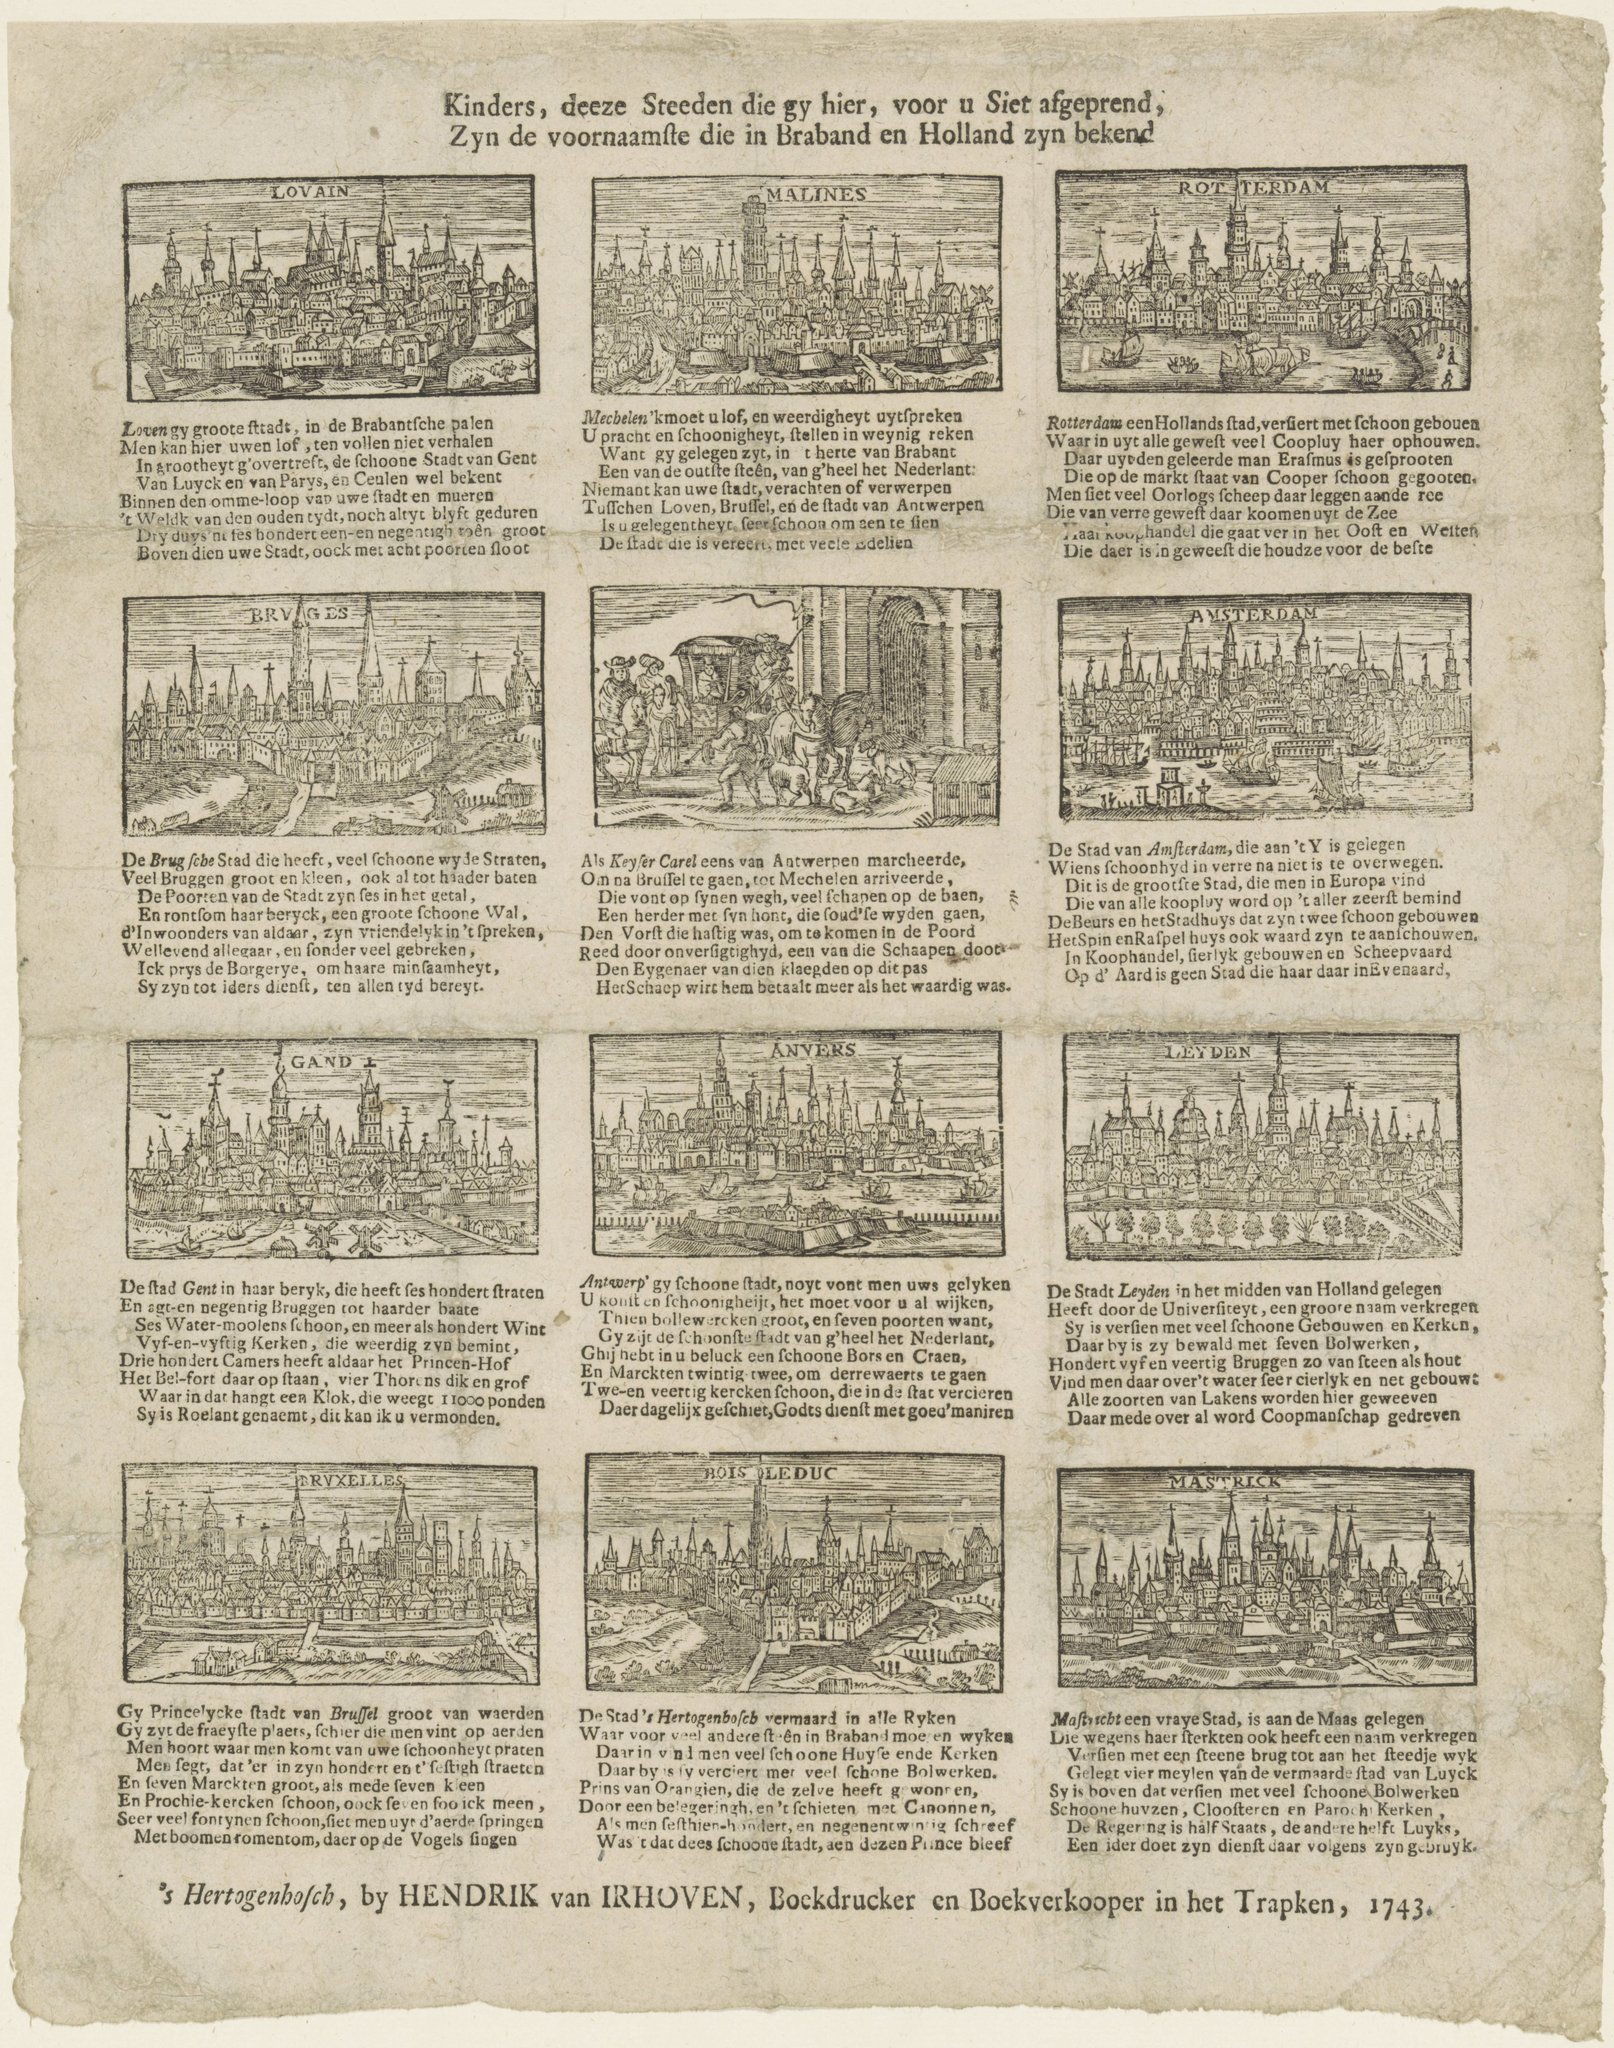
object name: popular print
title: Kinders, deeze steeden die gy hier, voor u siet afgeprend, / Zyn de voornaamste die in Braband en Holland zyn bekend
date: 1743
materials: paper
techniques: letterpress printing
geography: den bosch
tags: ghent, charles v (holy roman emperor and king of spain), city-view in general; 'veduta', leiden, antwerp, mechelen, den bosch, rotterdam, brussels, maastricht, amsterdam, bruges, louvain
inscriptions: collector's mark: Lugt 2760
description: Blad met 12 voorstellingen van gezichten van steden in Nederland en België, waaronder Rotterdam, Brugge, Brussel en Maastricht. Telkens de naam van de stad in het houtblok gesneden. Een plaatje stelt de wagen van keizer Karel voor, die een schaap doodrijdt te Mechelen. Onder elke afbeelding een achtregelig vers.